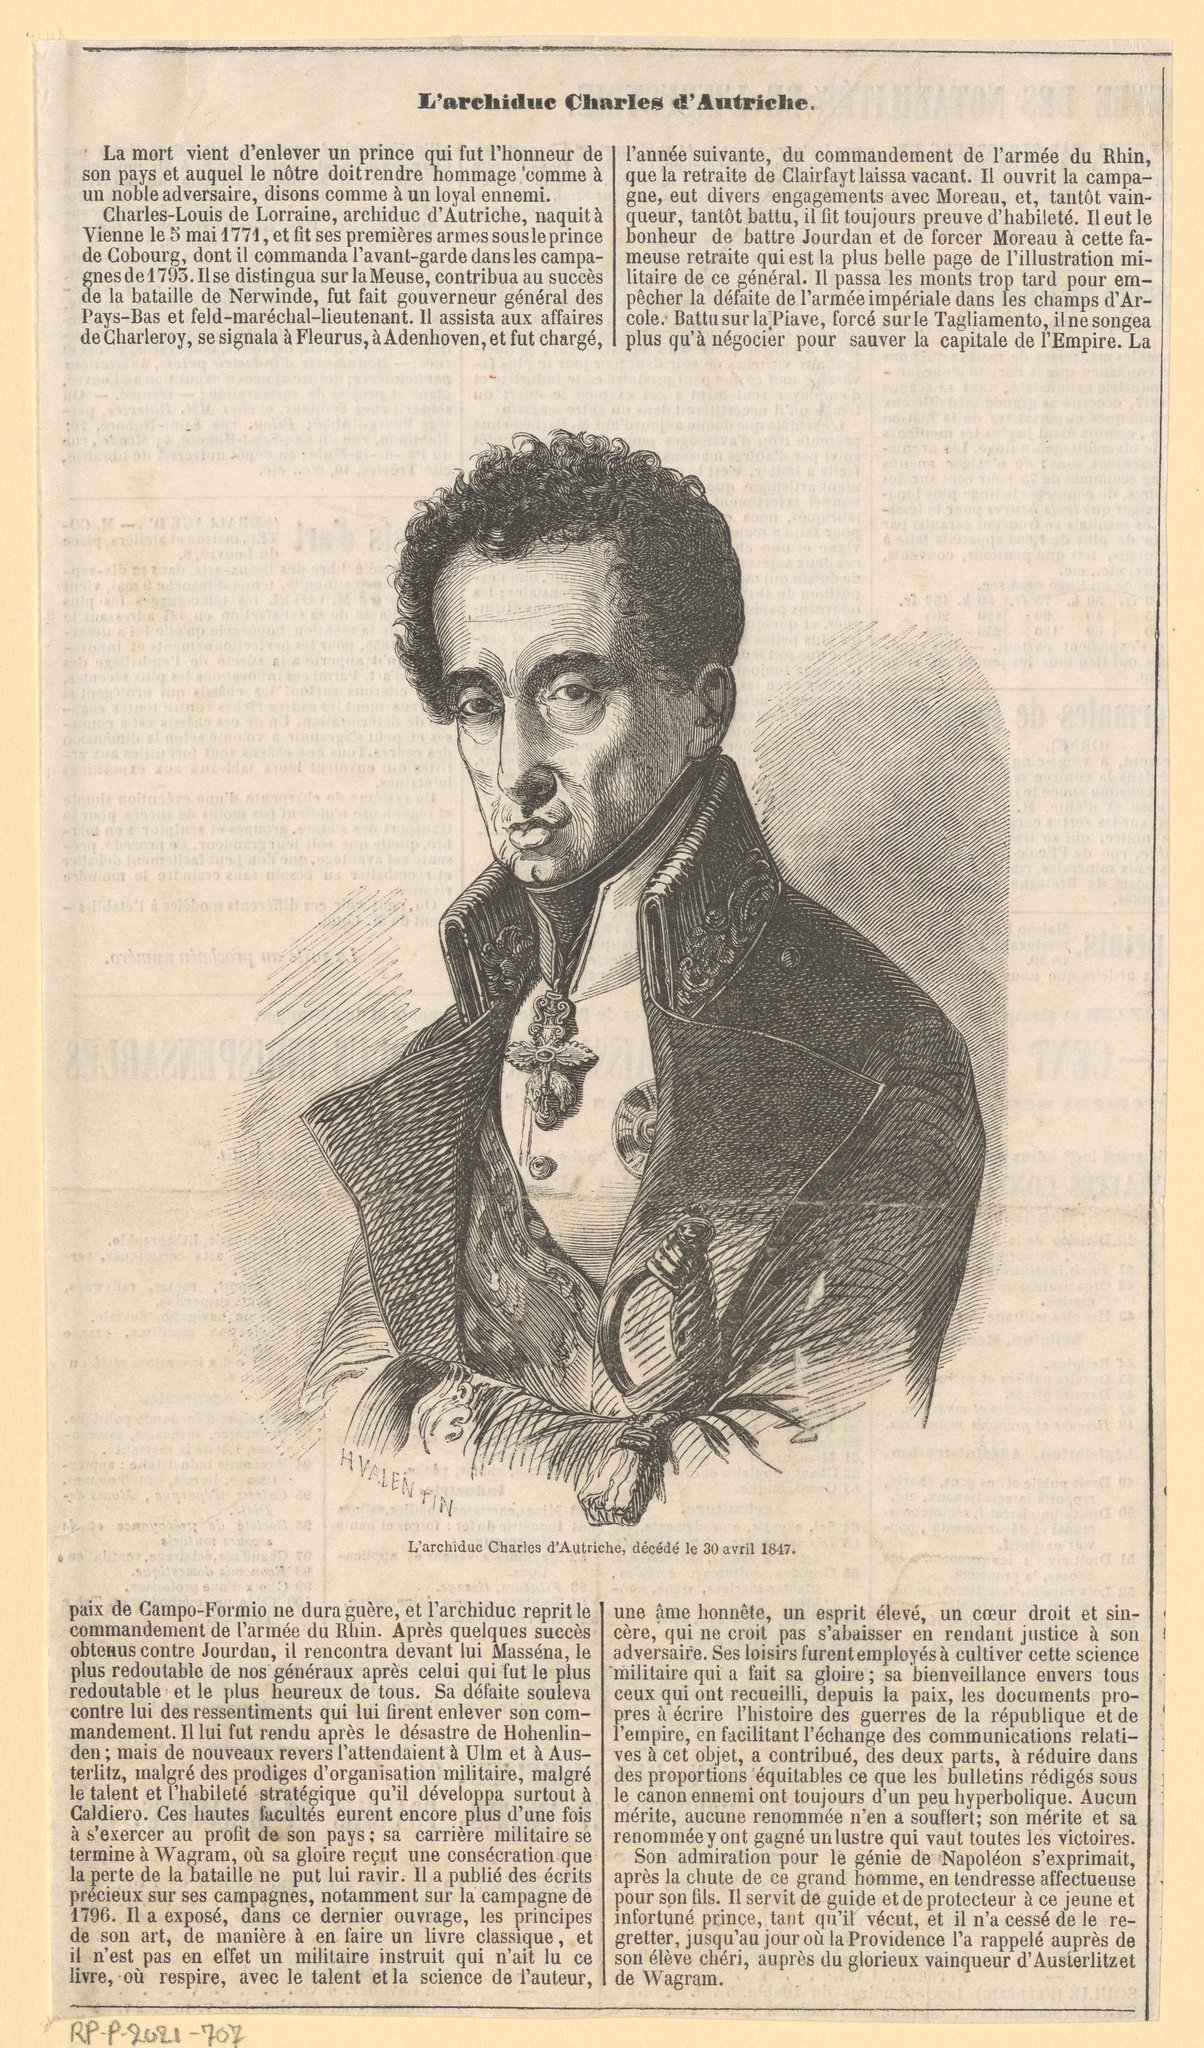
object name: print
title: Portret van Karel Lodewijk Johan, landvoogd der Zuidelijke Nederlanden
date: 1847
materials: paper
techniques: letterpress printing, engraving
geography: paris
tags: other sovereign, historical persons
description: Prent uit: L'Illustration 9 (1847), nr. 220, 15 mei 1847.